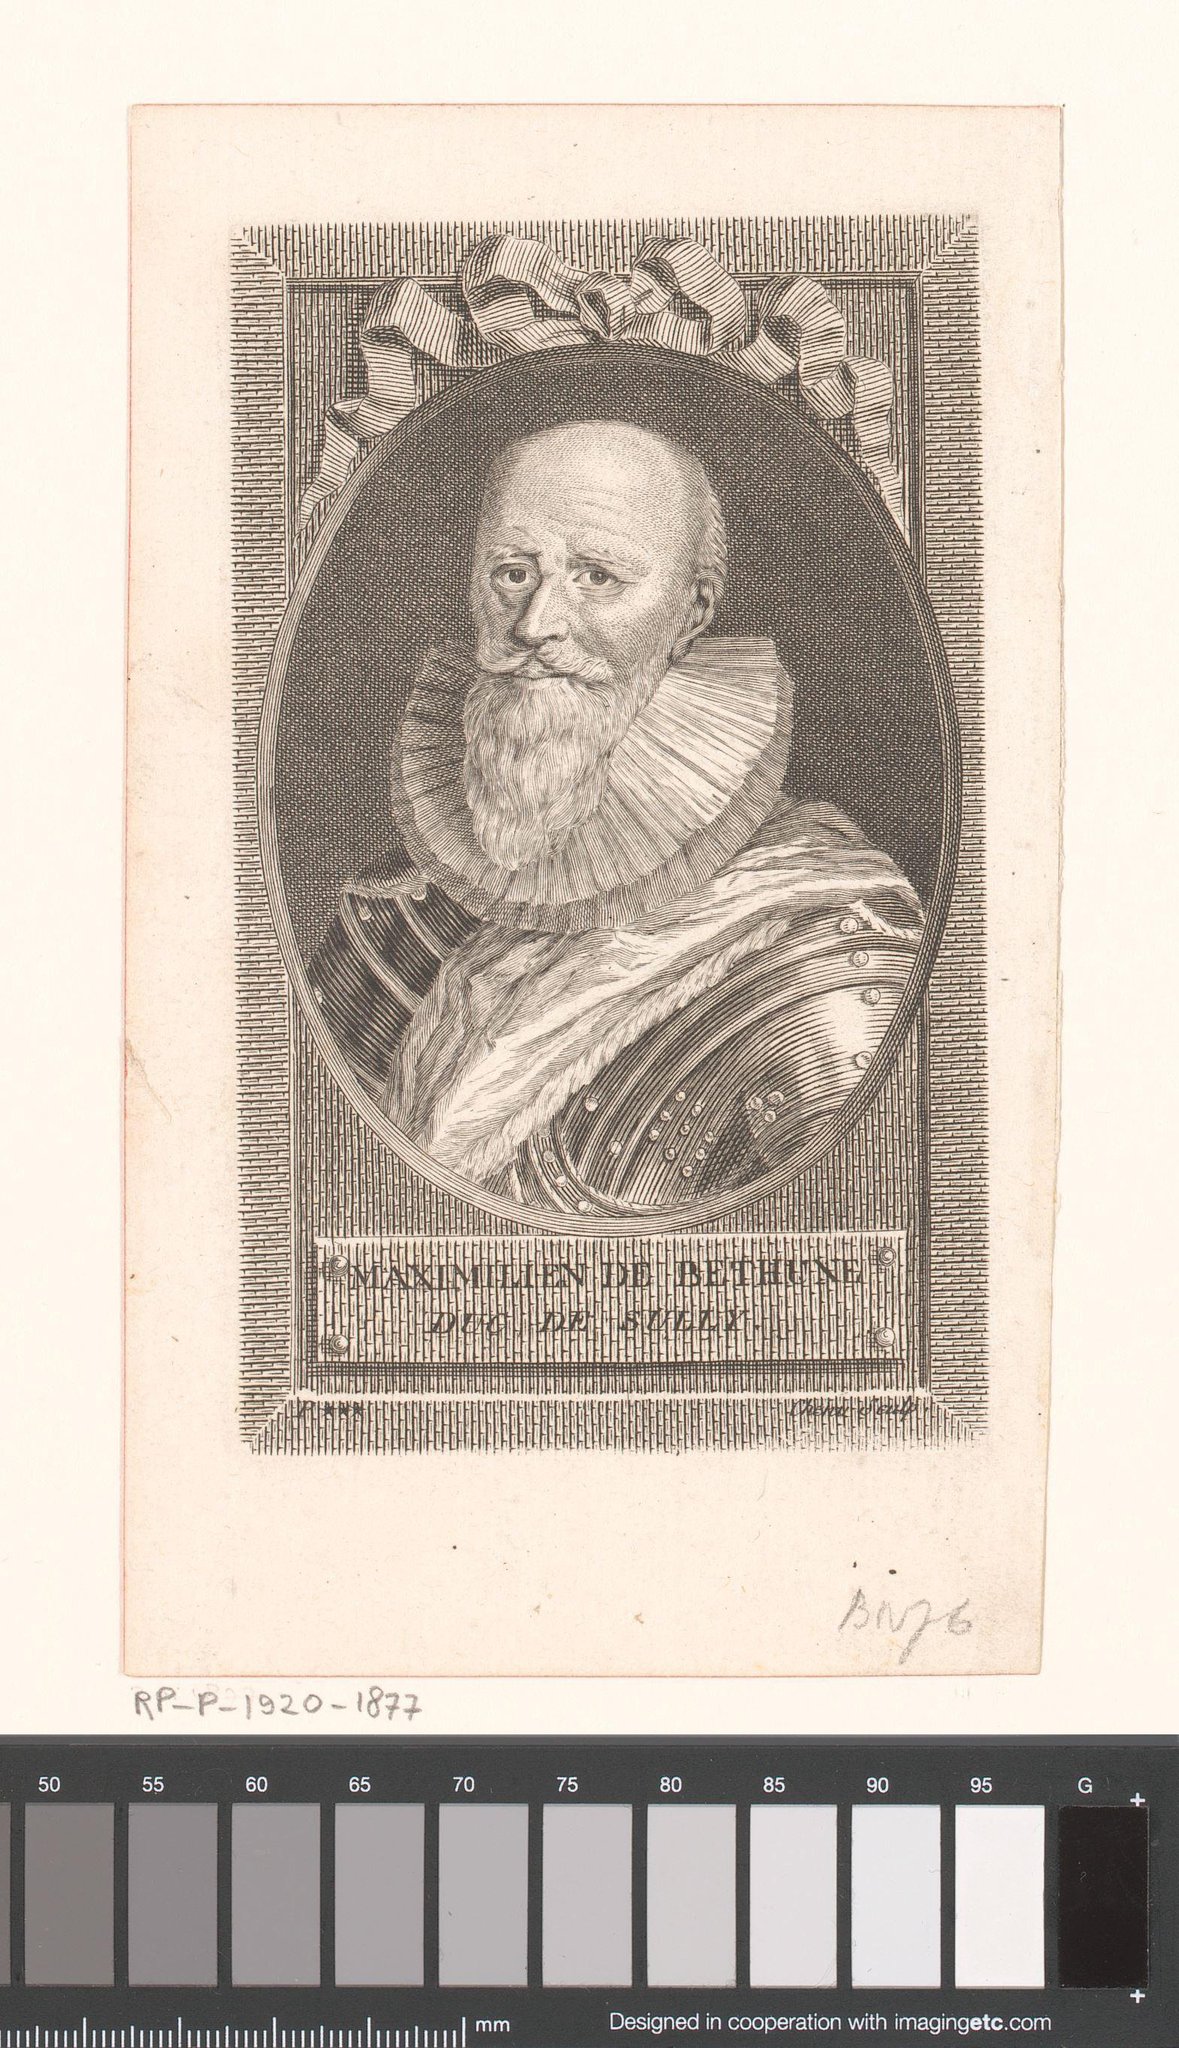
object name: book illustration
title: Portret van Maximilien de Béthune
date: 1766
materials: paper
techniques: engraving, etching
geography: paris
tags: maximilien de béthune (duke of sully), historical persons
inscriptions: collector's mark: Lugt 2228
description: Prent uit: Bury, Richard de. Histoire de la vie de Henri IV, roi de France et de Navarre (...). Parijs: Saillant, Charles, 1766.